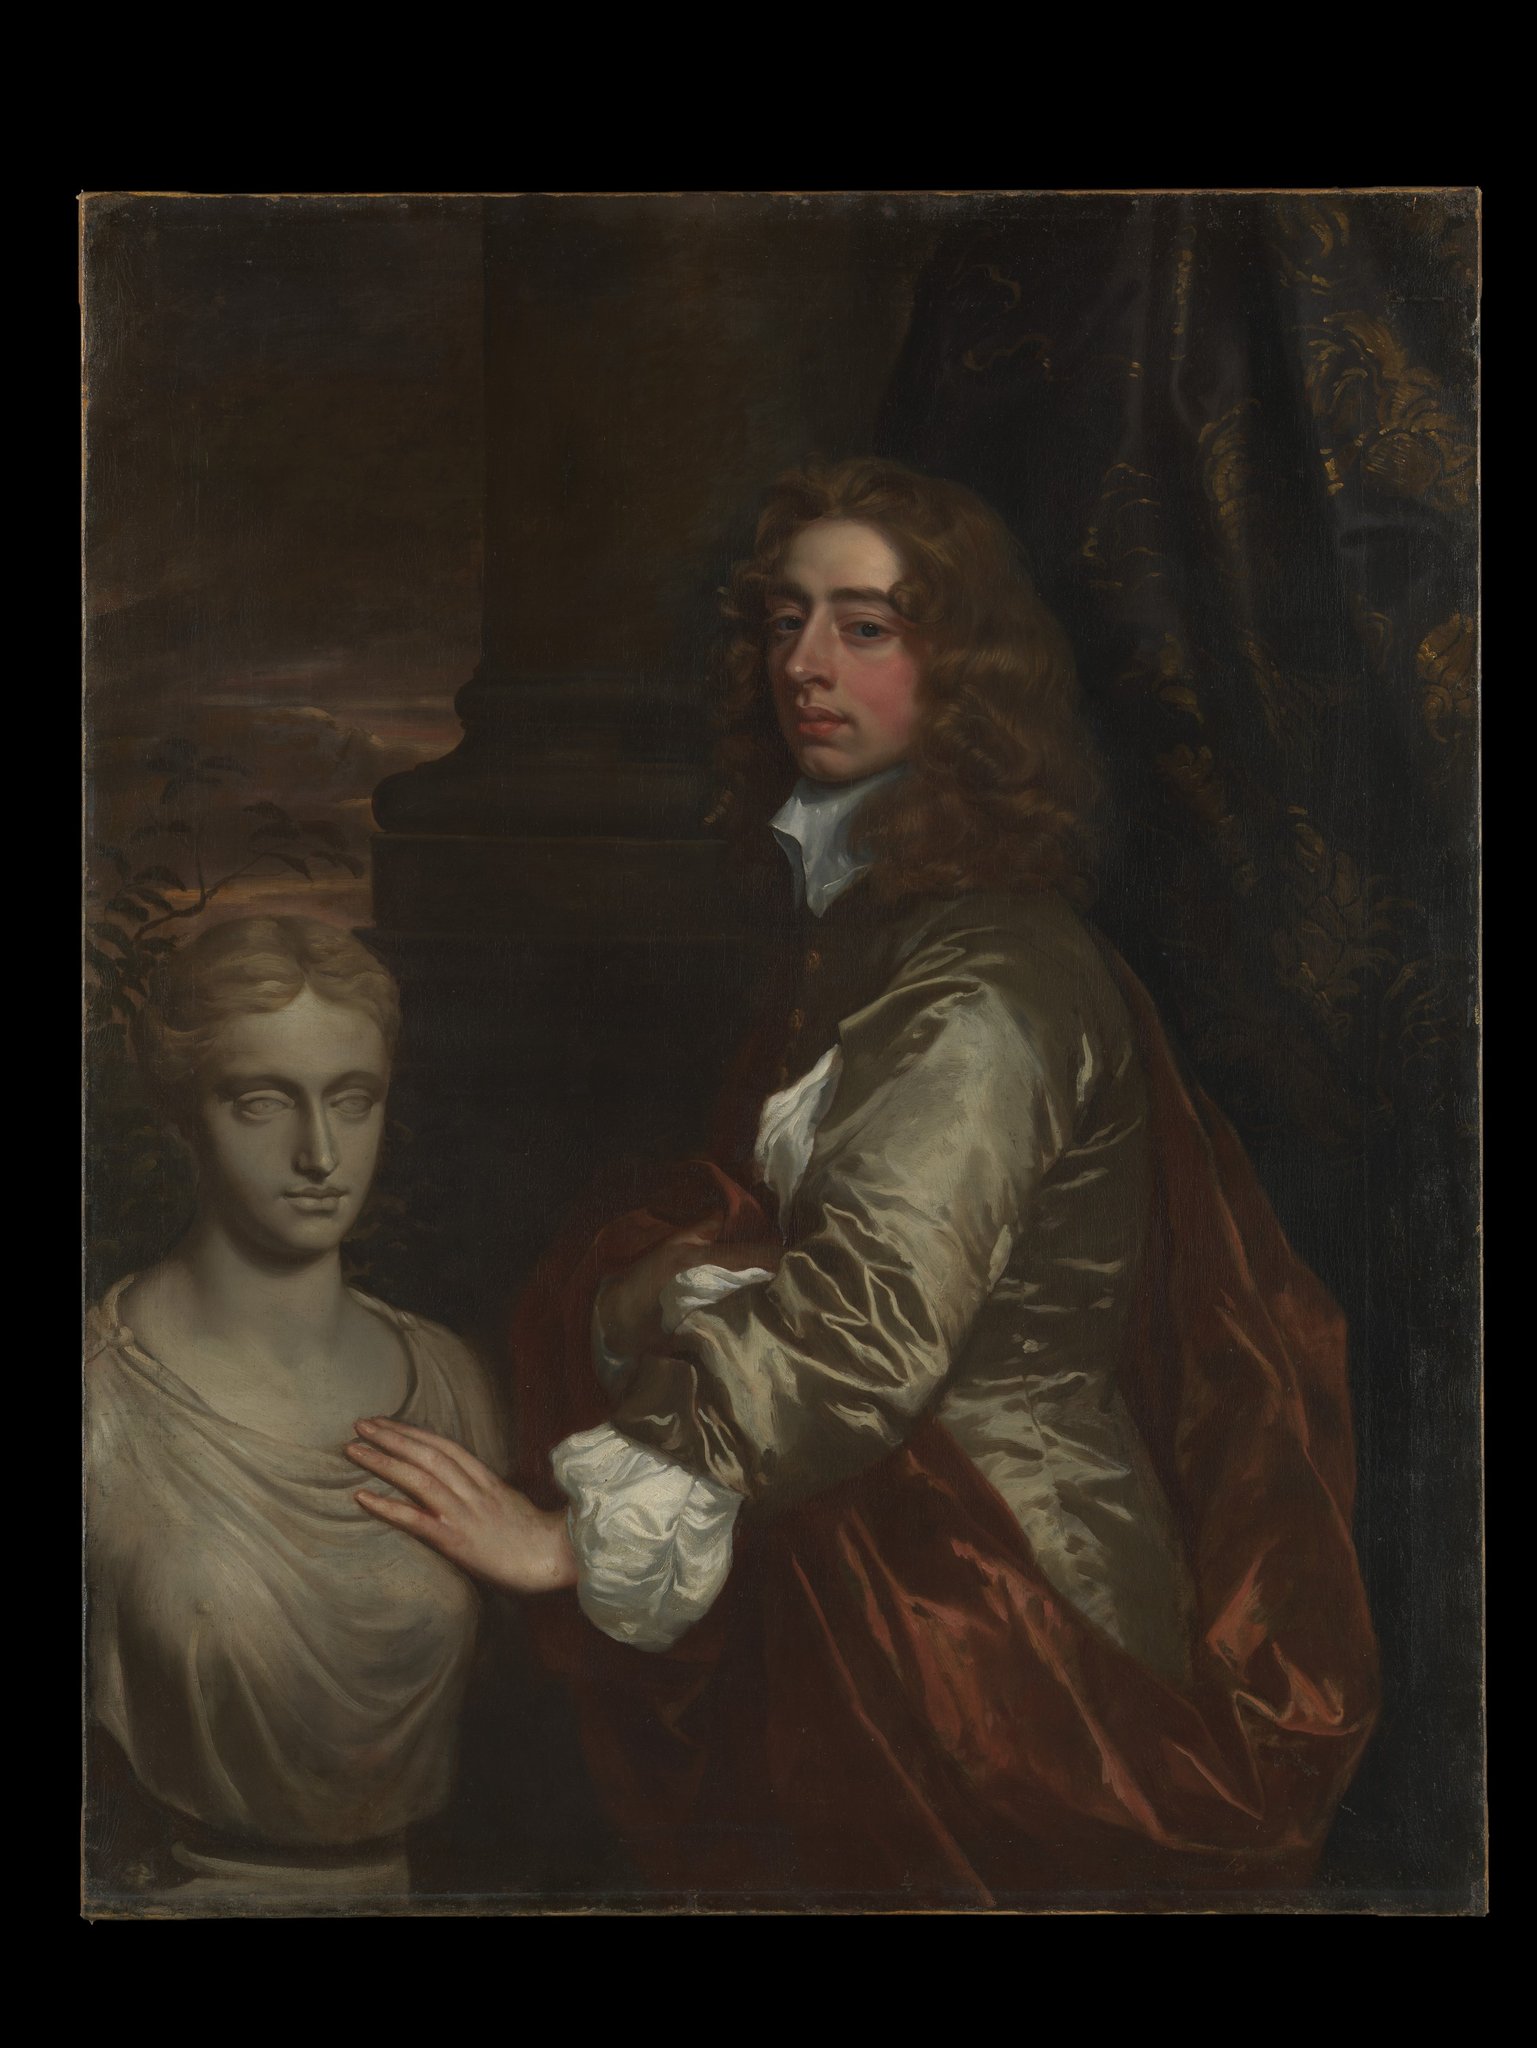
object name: painting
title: Sir Henry Capel (1638–1696)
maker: peter lely (sir)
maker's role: artist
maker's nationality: dutch, british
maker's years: 1618-1680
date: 1654-1664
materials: canvas, oil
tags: sculpture,men,portraits